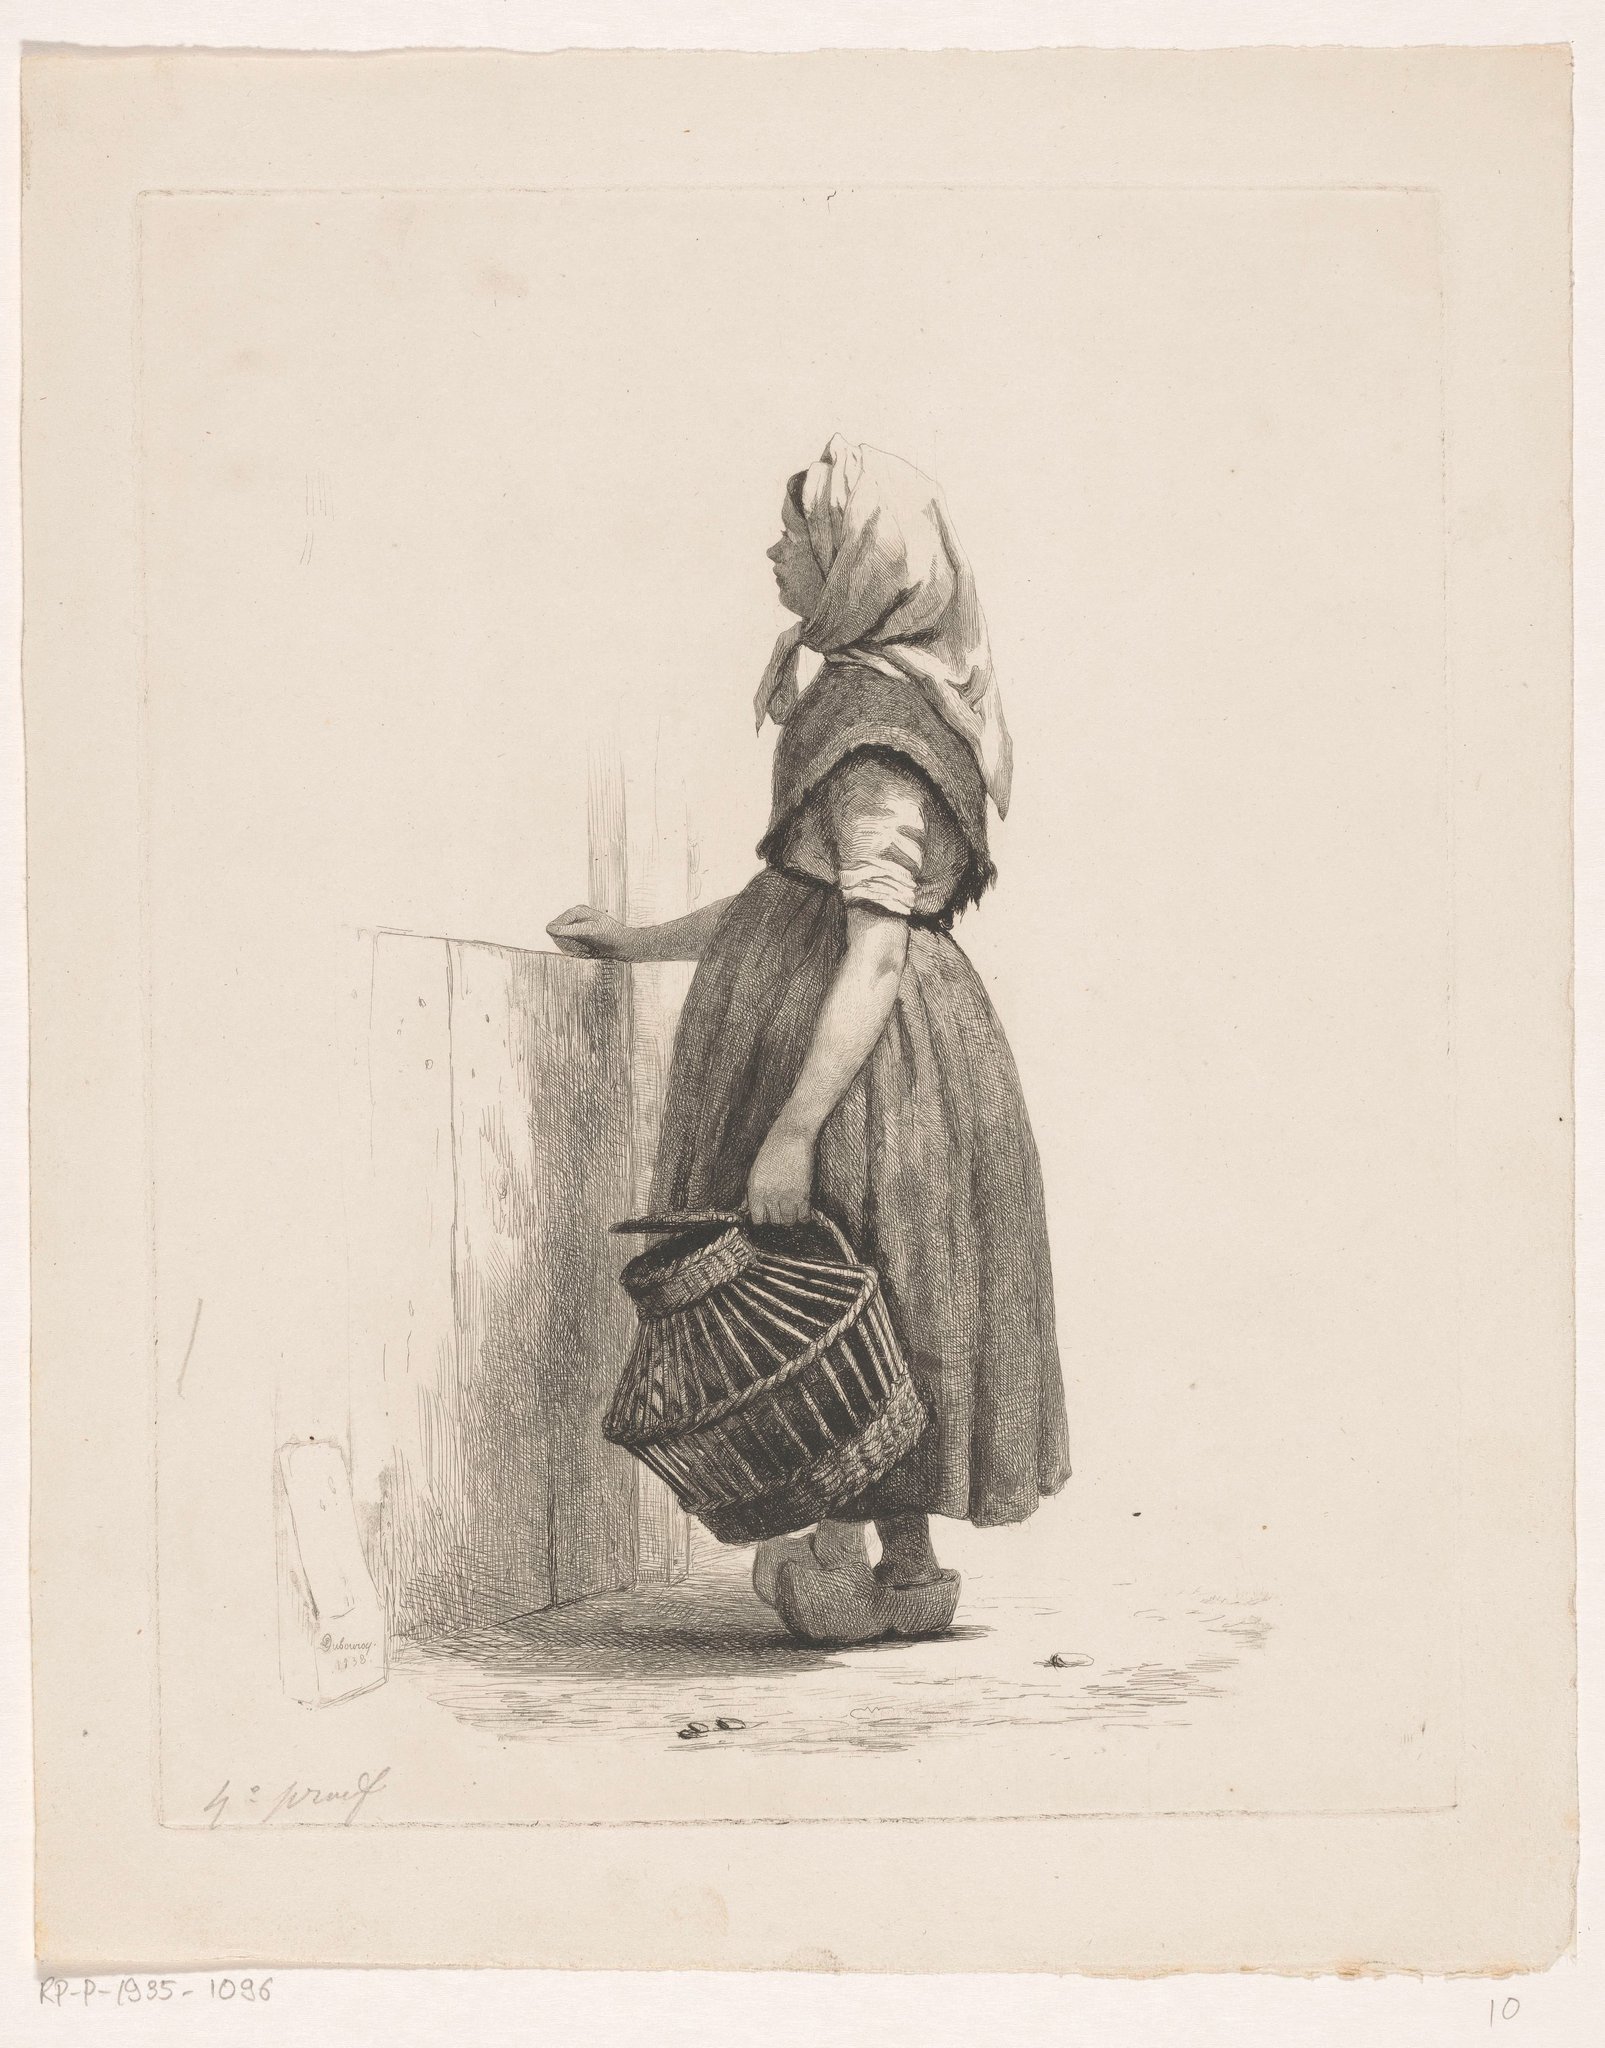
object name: print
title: Staand meisje met pluimveemand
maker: pierre louis dubourcq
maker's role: draughtsman, painter, print maker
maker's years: 1815-1873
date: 1838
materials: paper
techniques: drypoint, etching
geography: netherlands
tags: fowl (cock, hen, chicken, etc.) (+ animal cage)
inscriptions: collector's mark: Lugt 2228